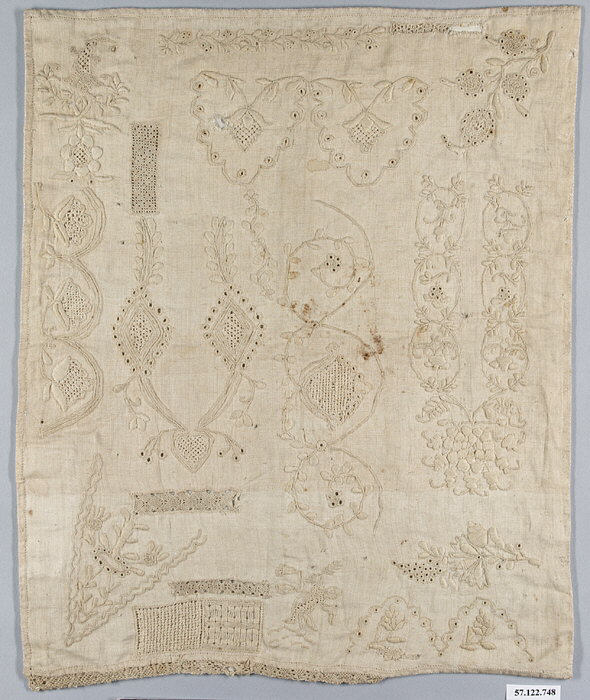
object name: sampler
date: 1701-1800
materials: linen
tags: flowers